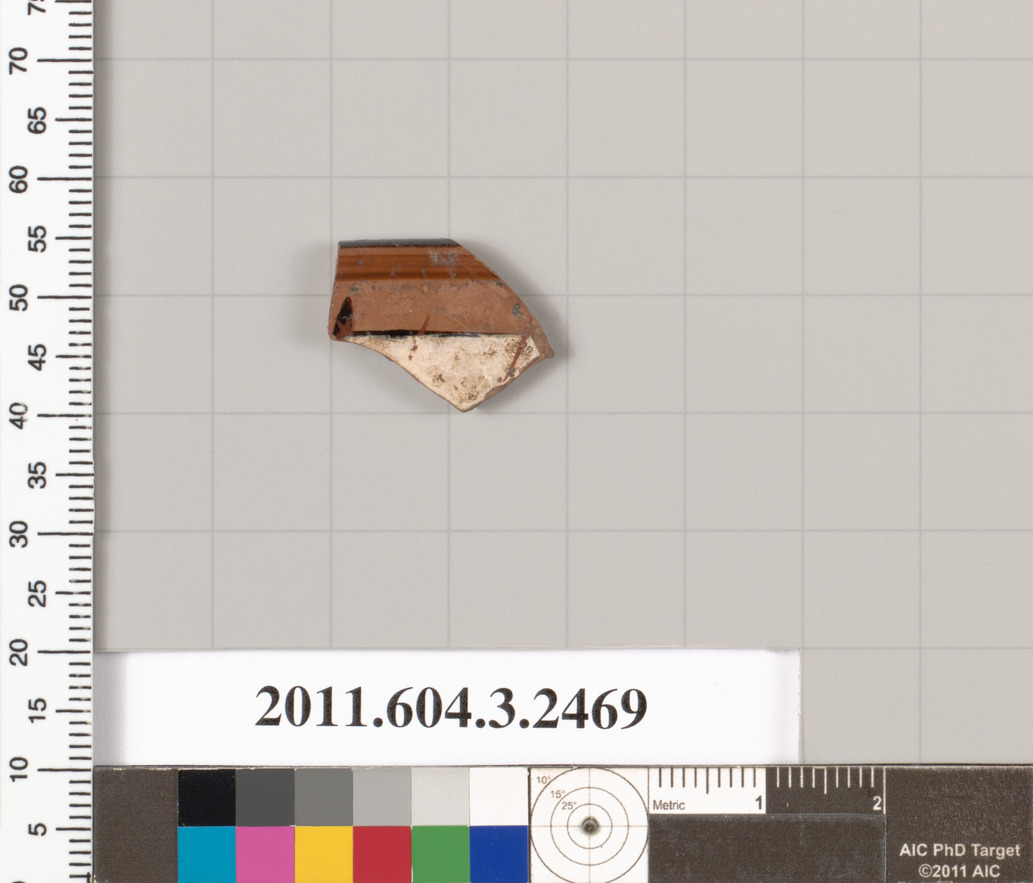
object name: kylix fragment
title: Terracotta rim fragment of a kylix: eye-cup (drinking cup)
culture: greek, attic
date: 520-510 BCE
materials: terracotta